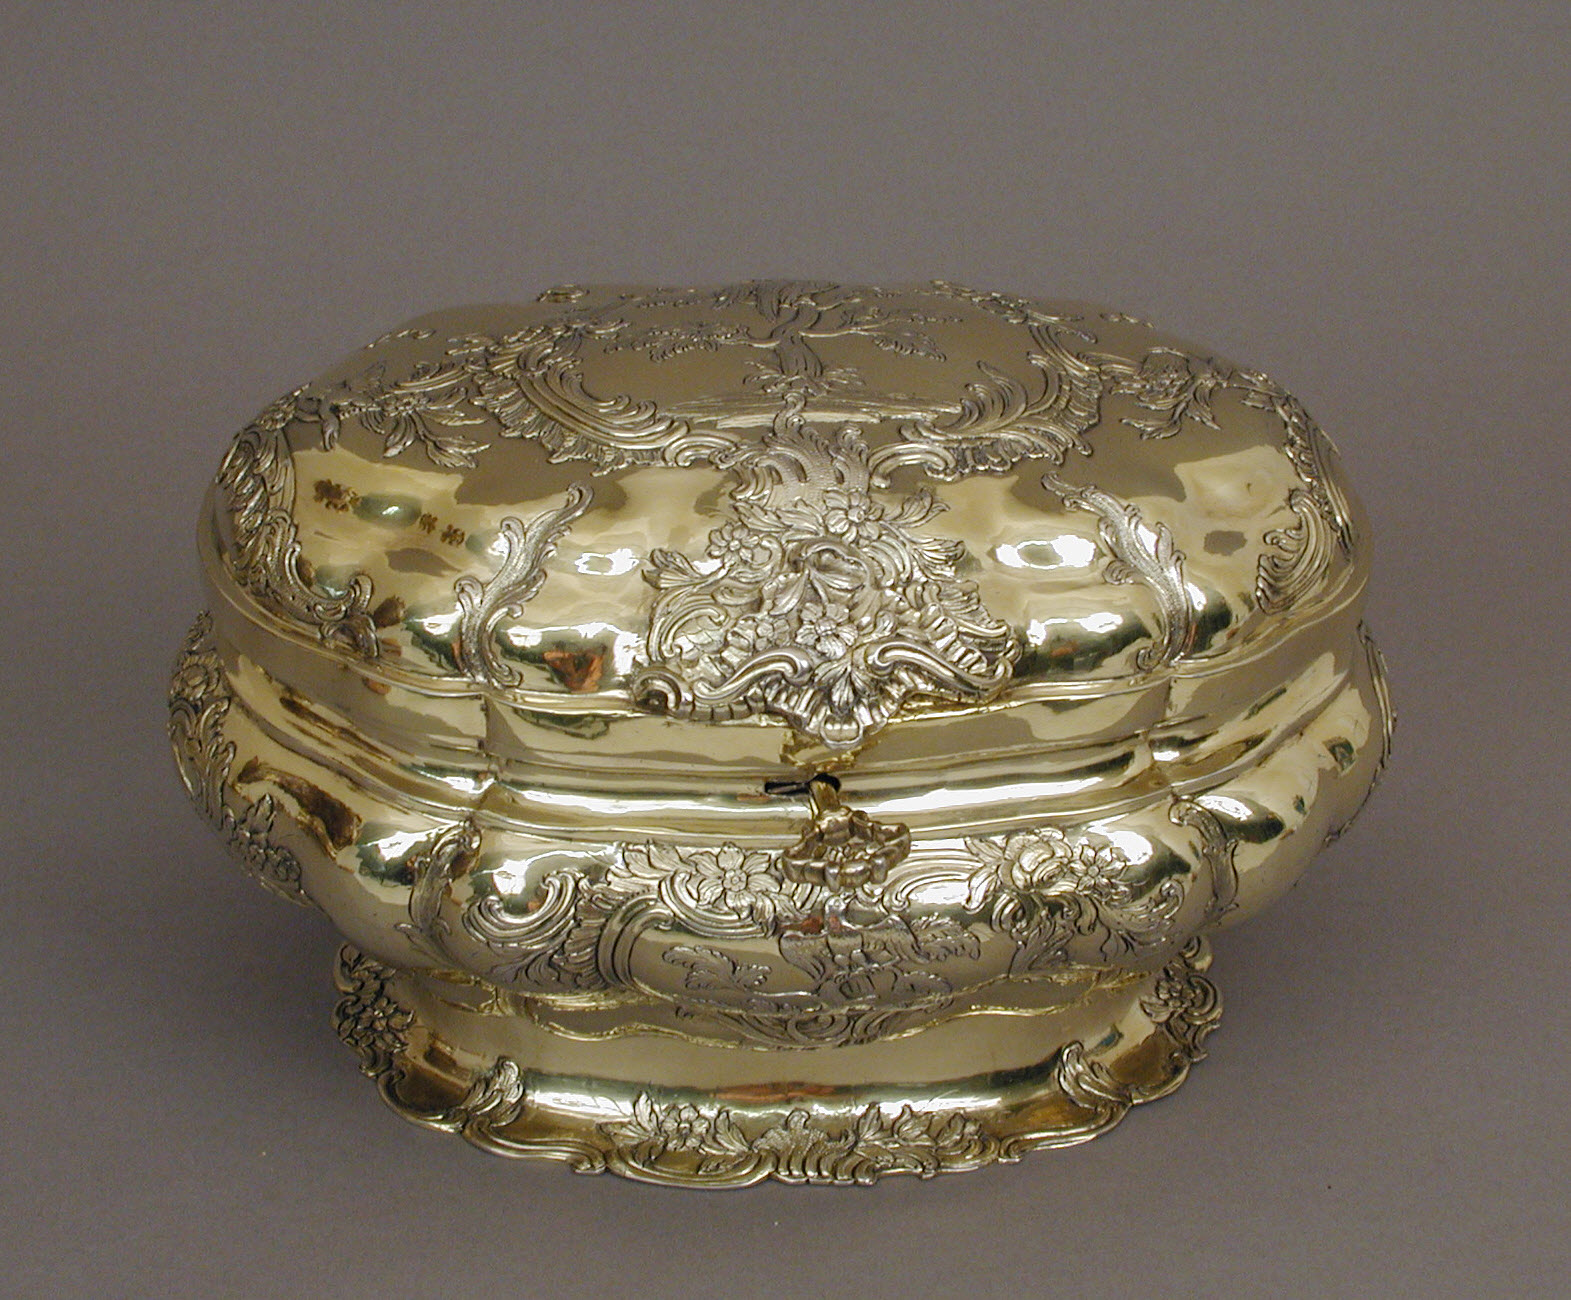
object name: box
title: Large oval box (one of a pair)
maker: gottlieb satzger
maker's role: maker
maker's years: 1709-1783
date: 1775-1777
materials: silver gilt